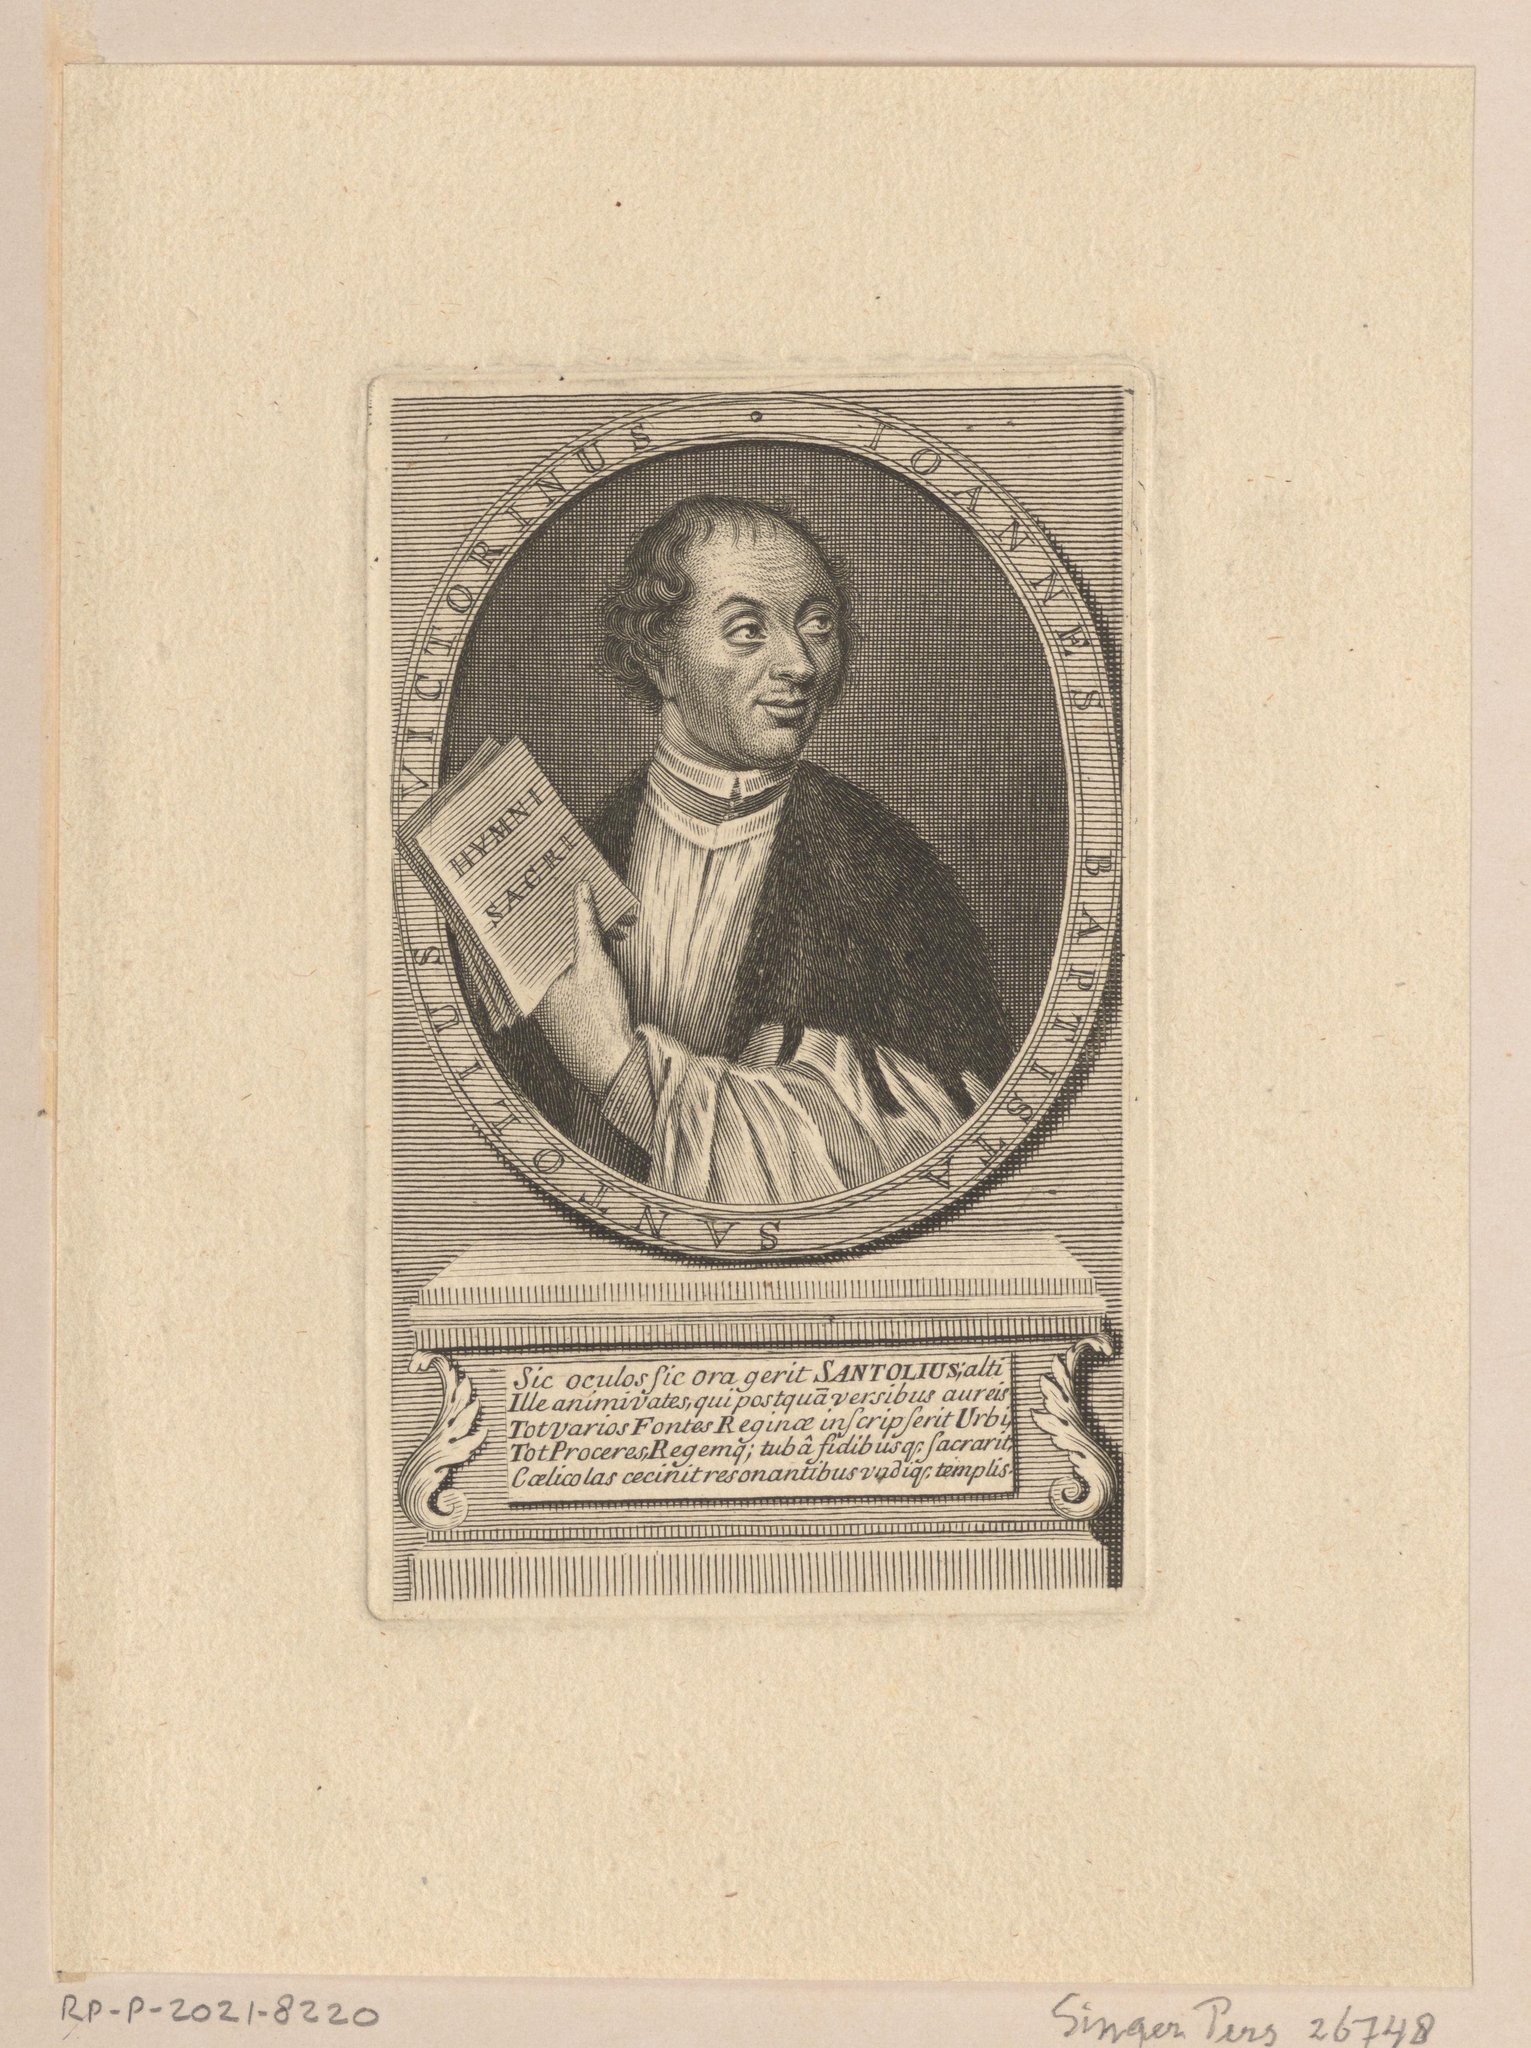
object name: print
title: Portret van Jean de Santeul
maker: Anonymous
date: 1689-1750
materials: paper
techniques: engraving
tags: paris, jean de santeul, historical persons, writer, poet, author, printed matter